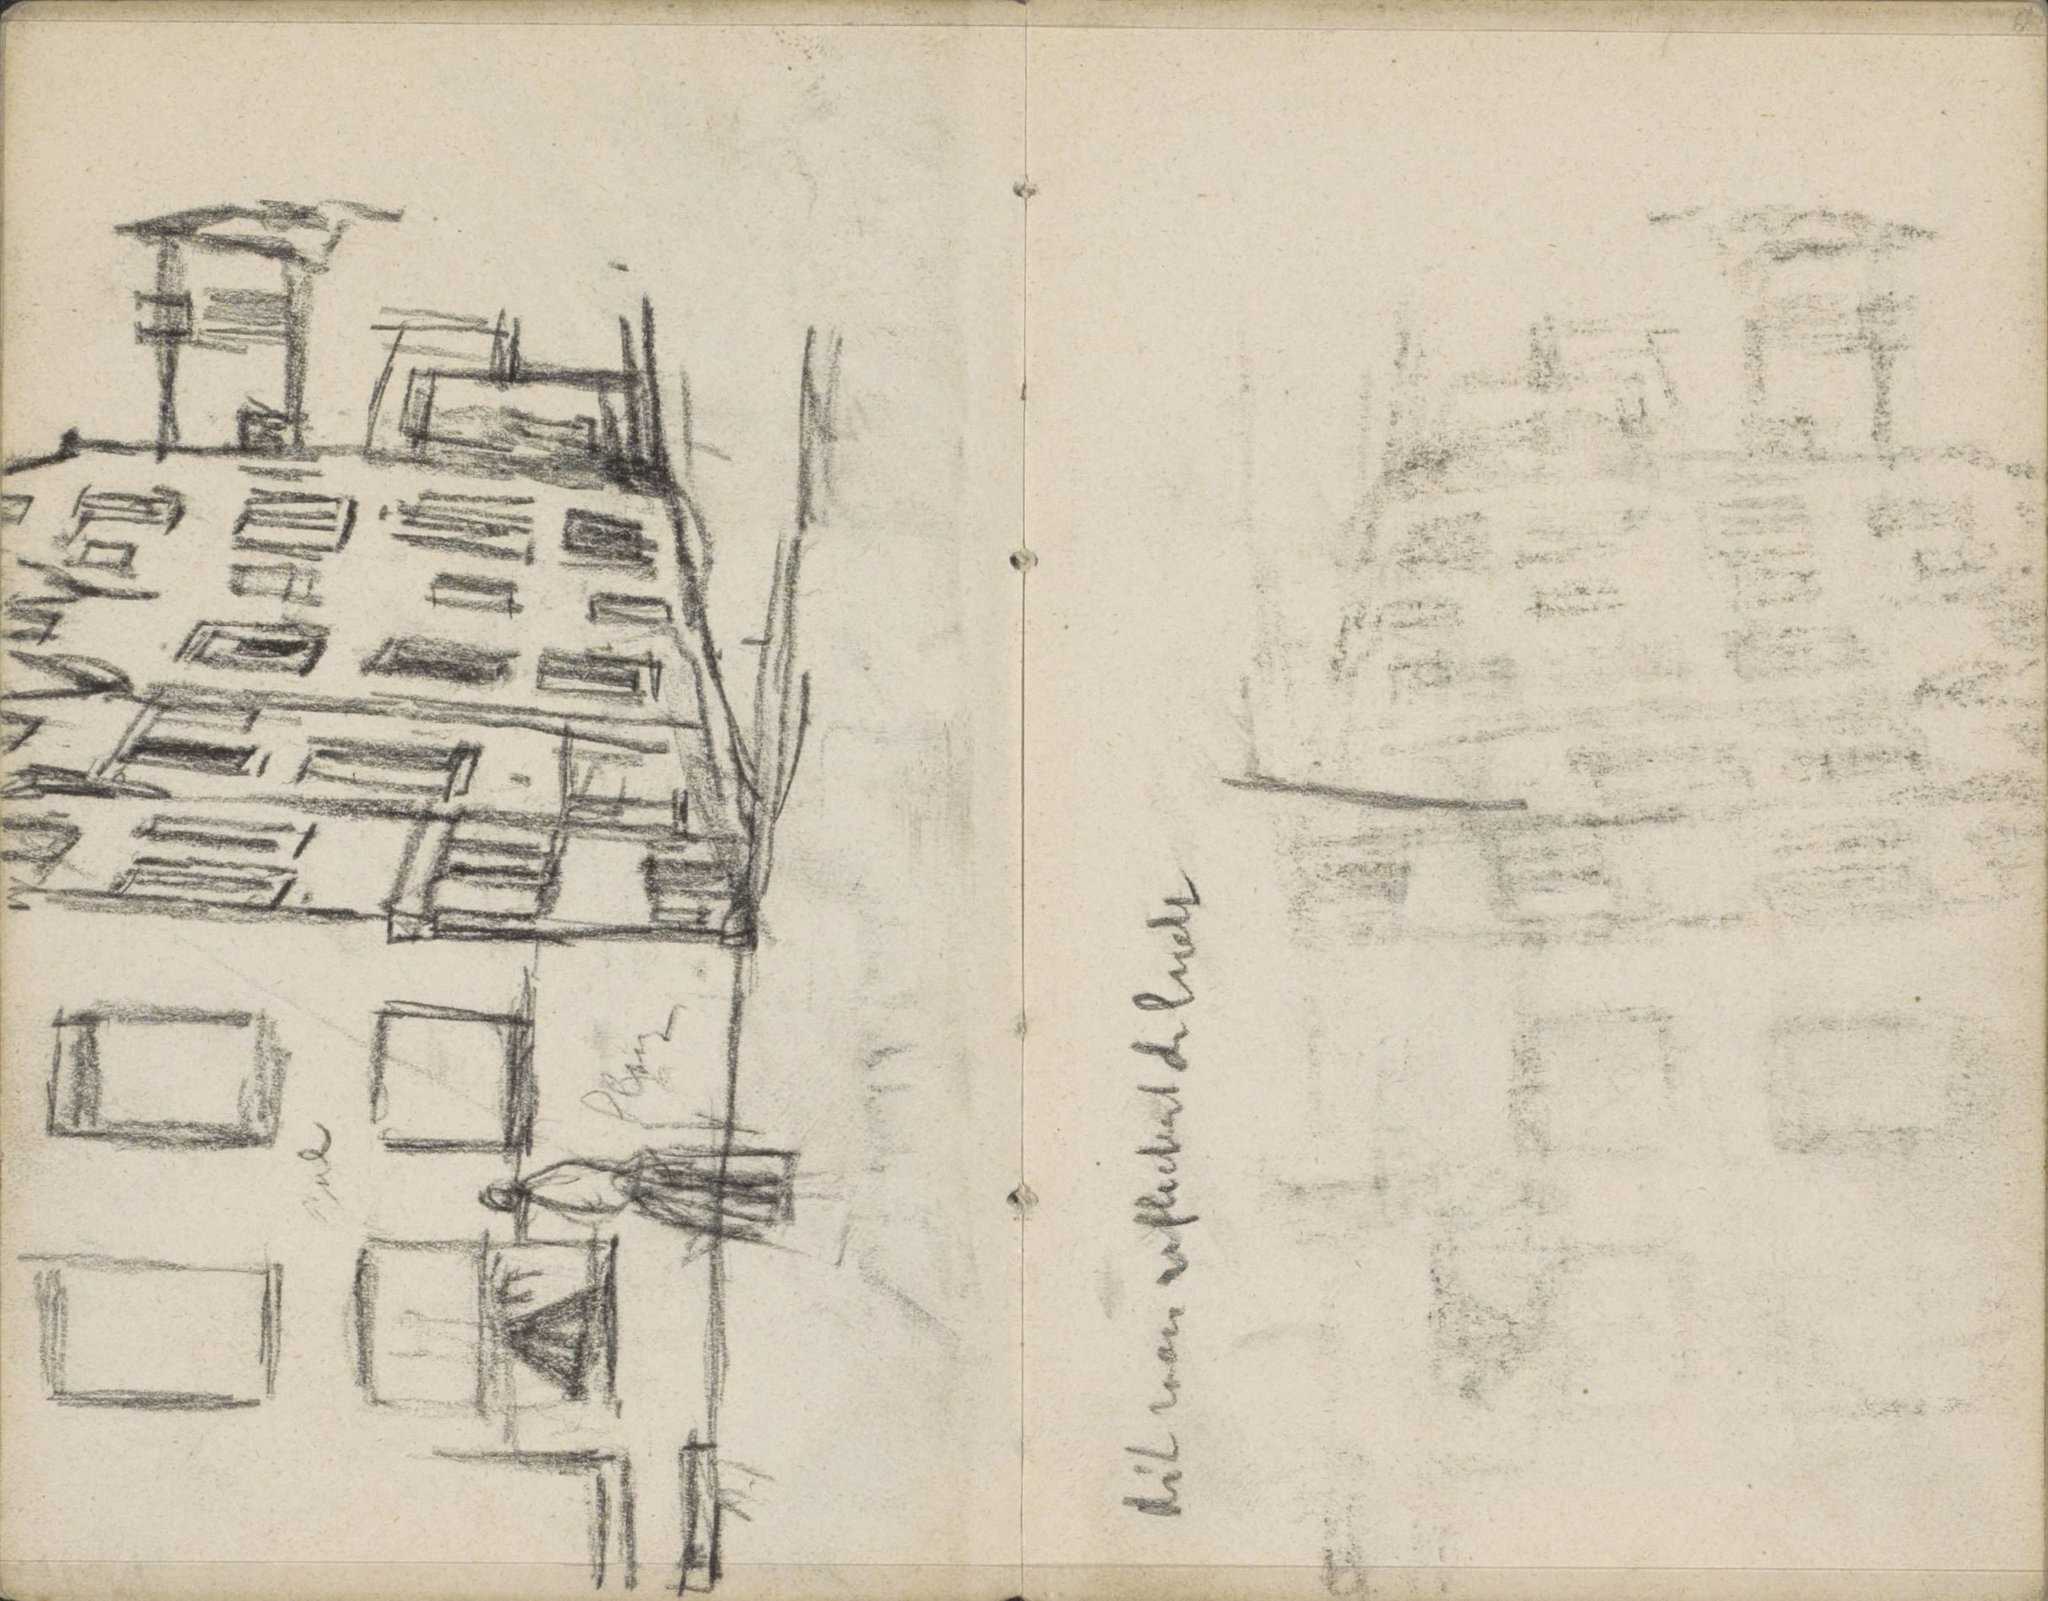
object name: sketchbook leaf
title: Gezicht op het Spui te Amsterdam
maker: george hendrik breitner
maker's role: draughtsman, painter, print maker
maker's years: 1857-1923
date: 1907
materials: chalk, paper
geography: amsterdam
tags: urban housing, street (+ city(-scape) with figures, staffage)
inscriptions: : ‘[...] reflecteert de lucht’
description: Gezicht op het Spui te Amsterdam. Vooraan een figuur. Pagina 5 en pagina 6 uit een schetsboek met 46 bladen vervaardigd in Amsterdam, Rotterdam en Haarlem.